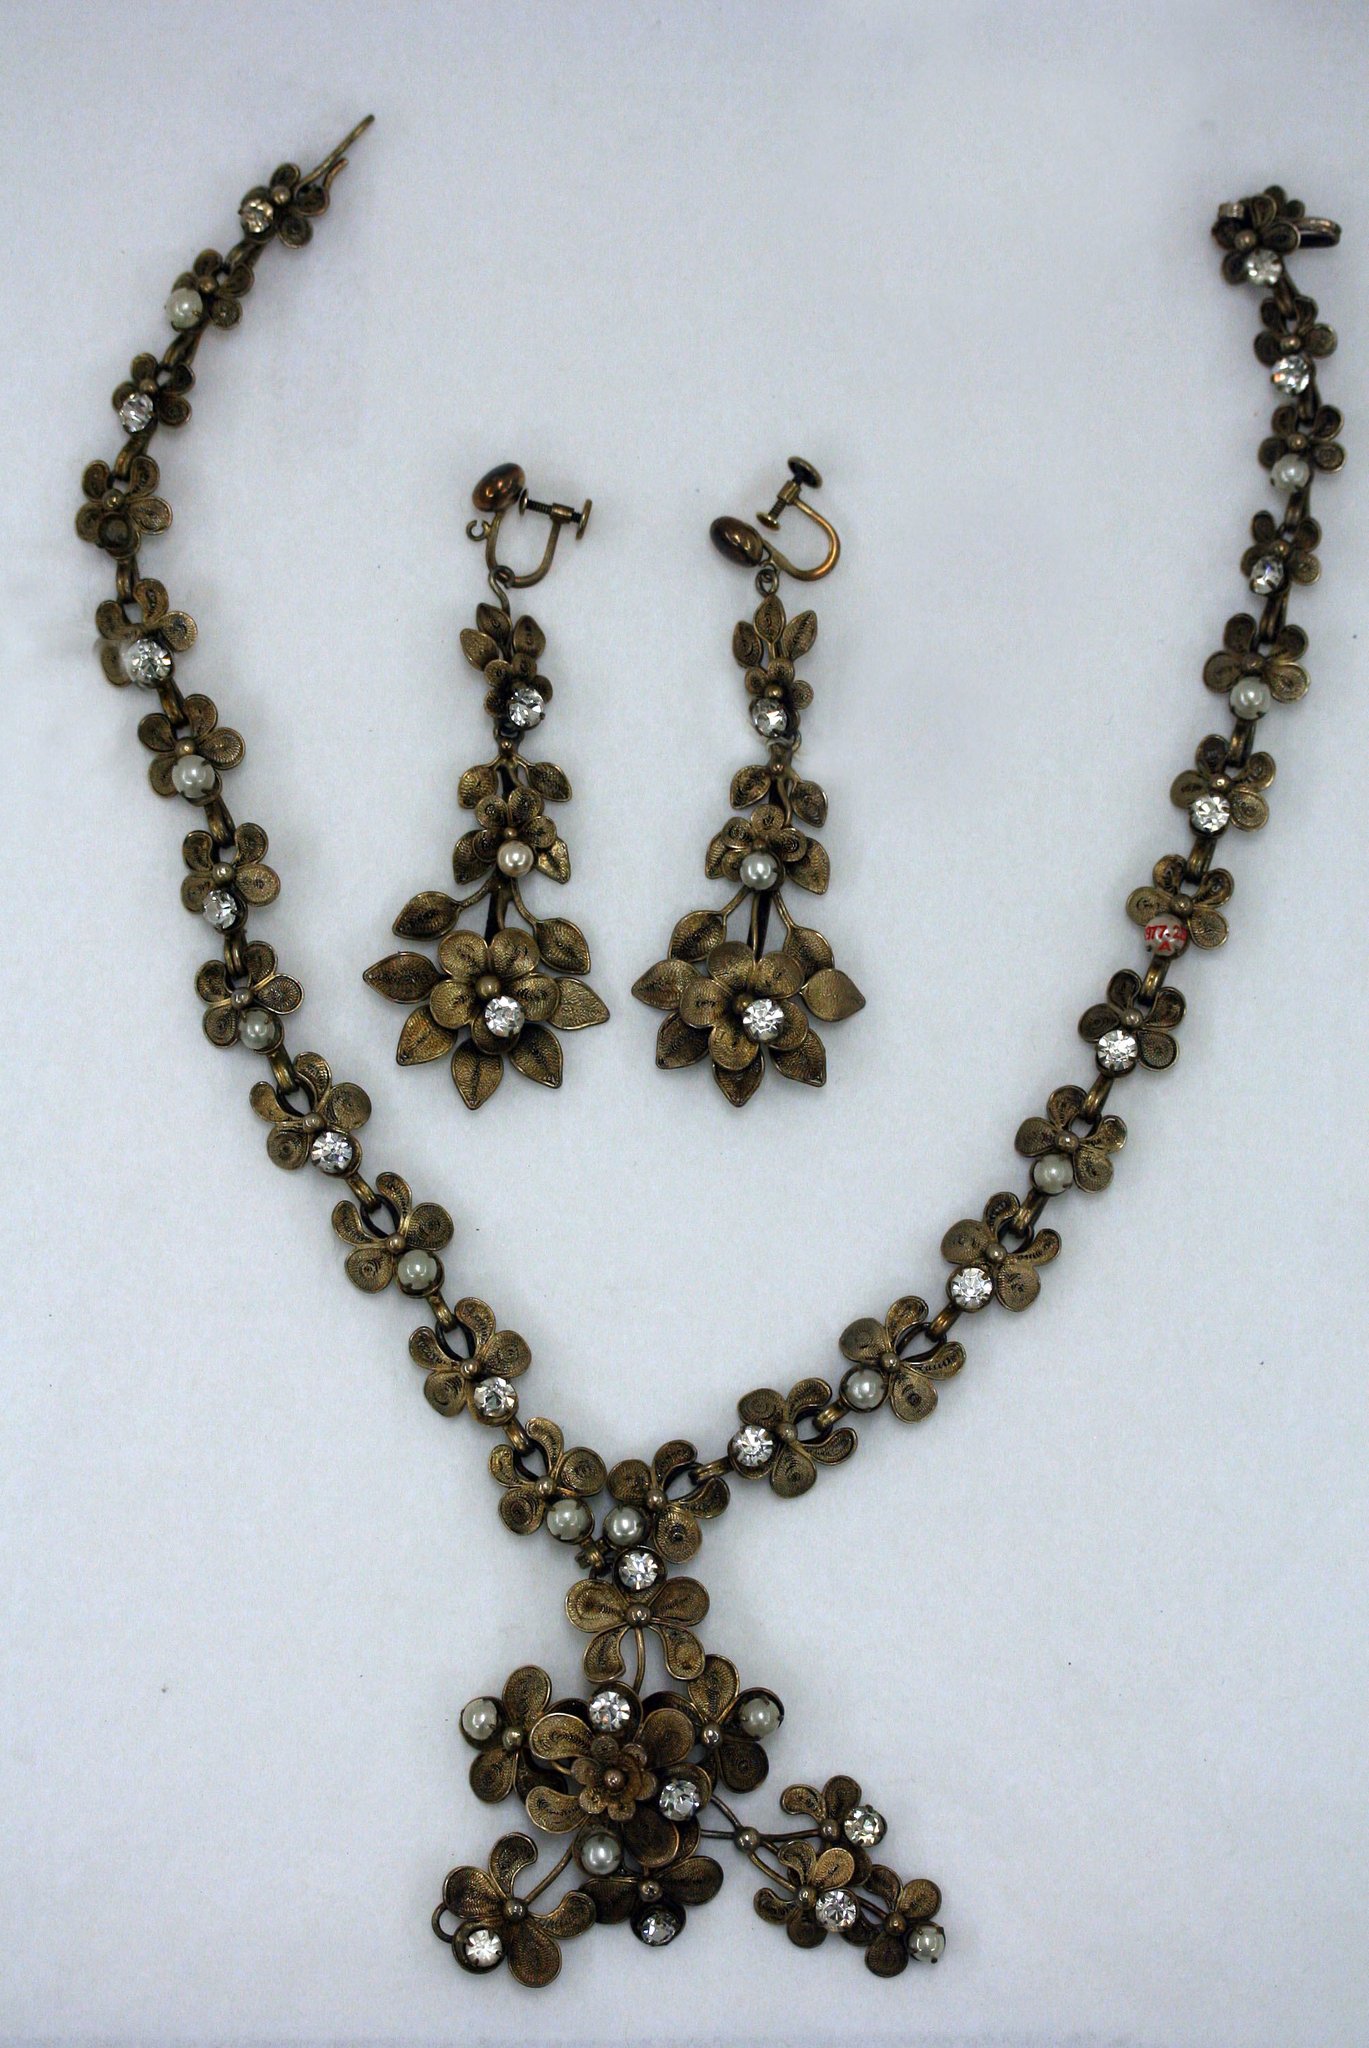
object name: jewelry set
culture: european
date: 1860-1869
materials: pearl, silver